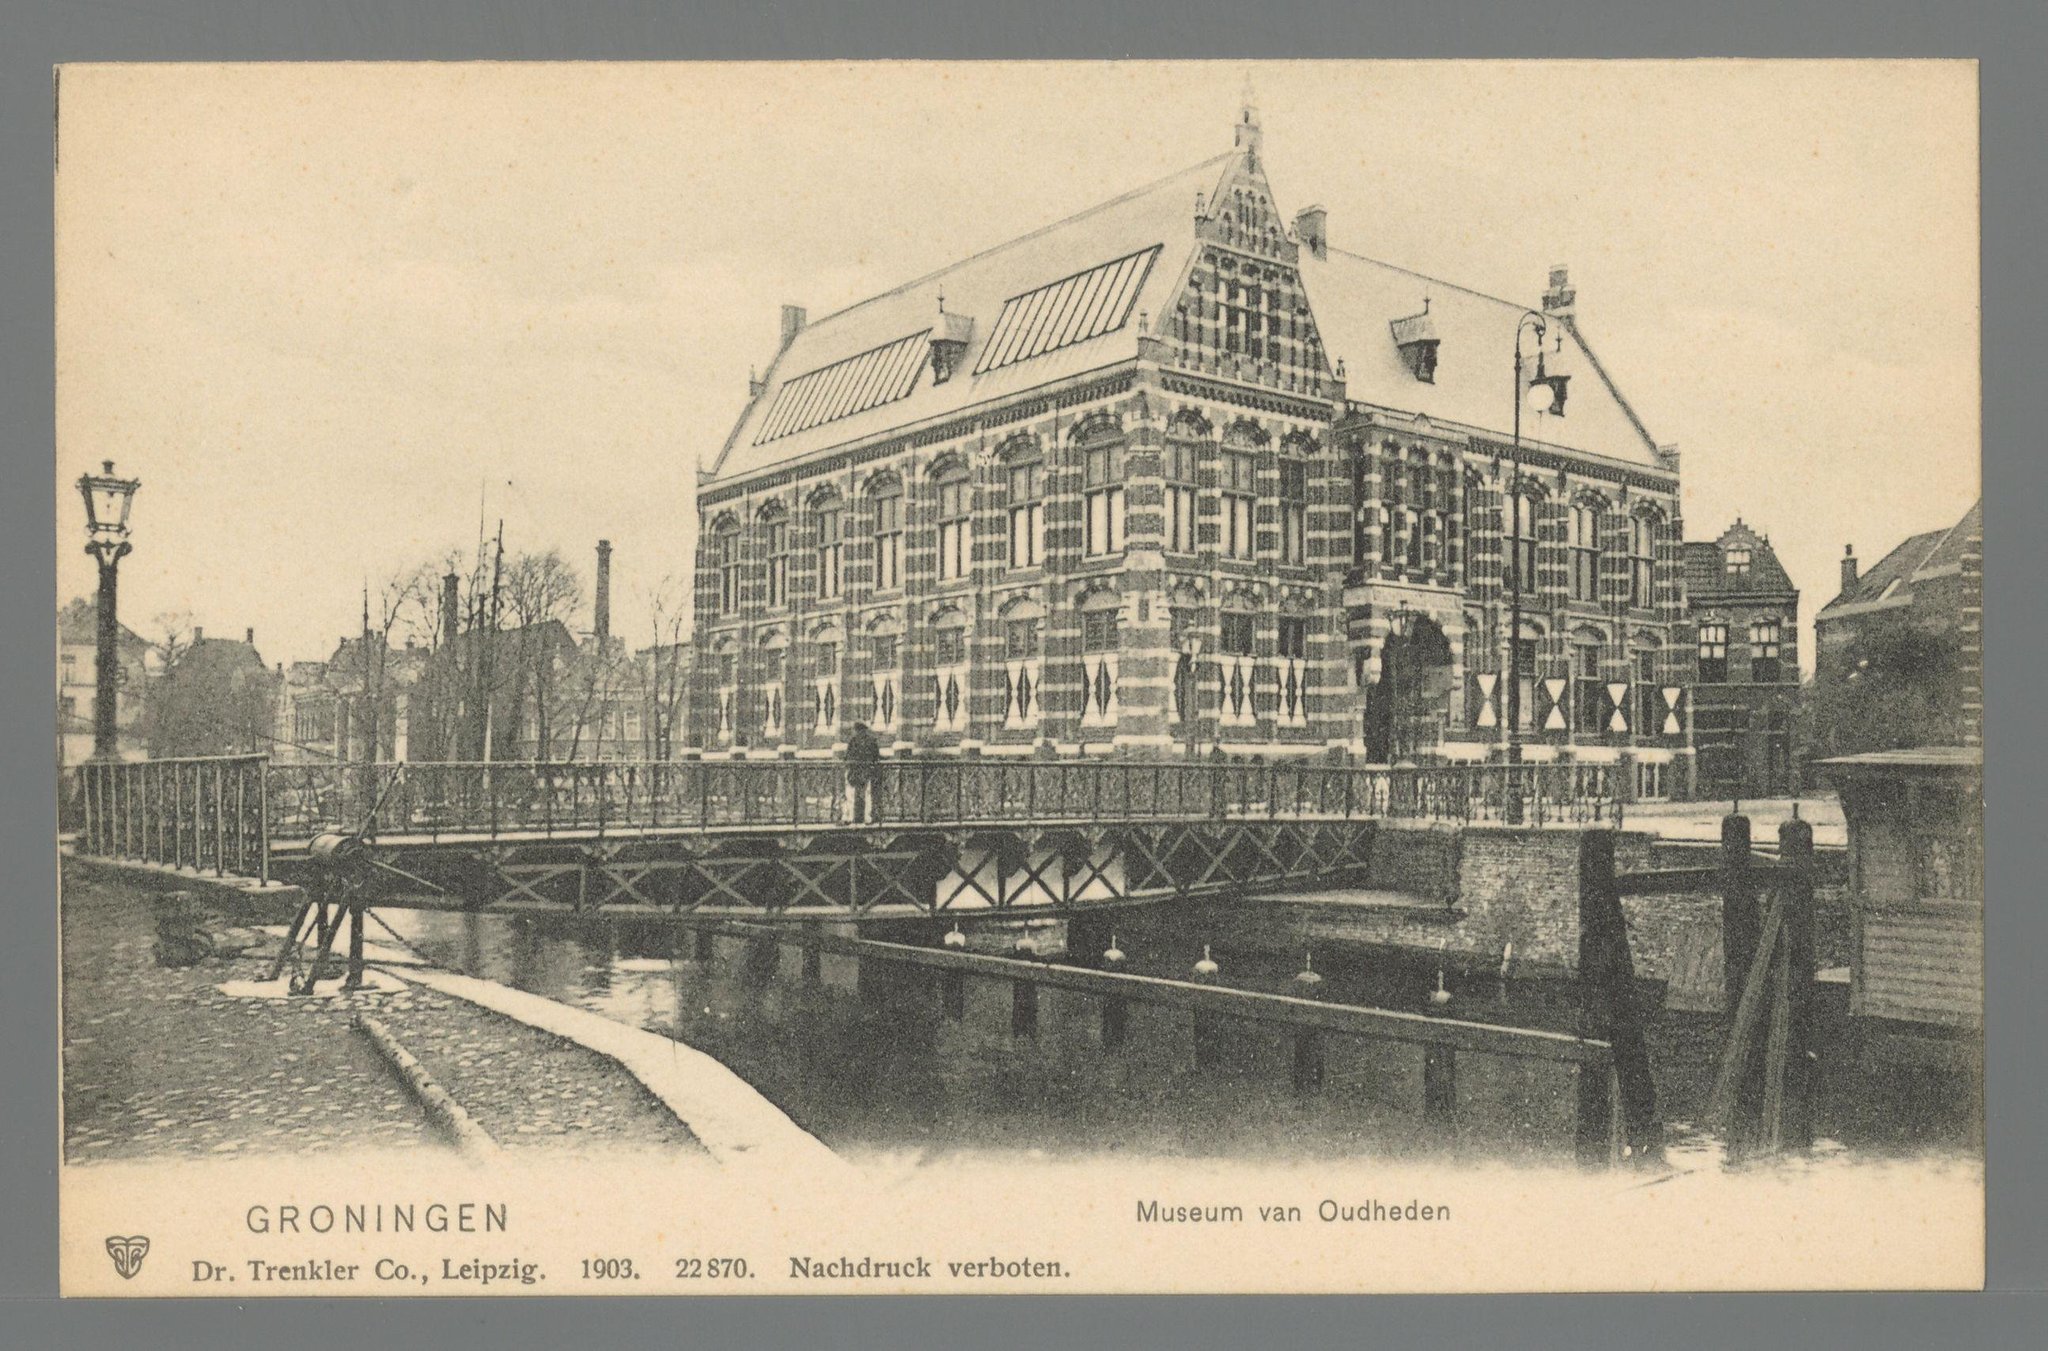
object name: photomechanical print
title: Groningen. Museum van Oudheden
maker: Anonymous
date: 1903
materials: cardboard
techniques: photograph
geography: groningen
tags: canals, waters (in city), permanent exhibition, museum, bridge in city across river, canal, etc.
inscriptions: date